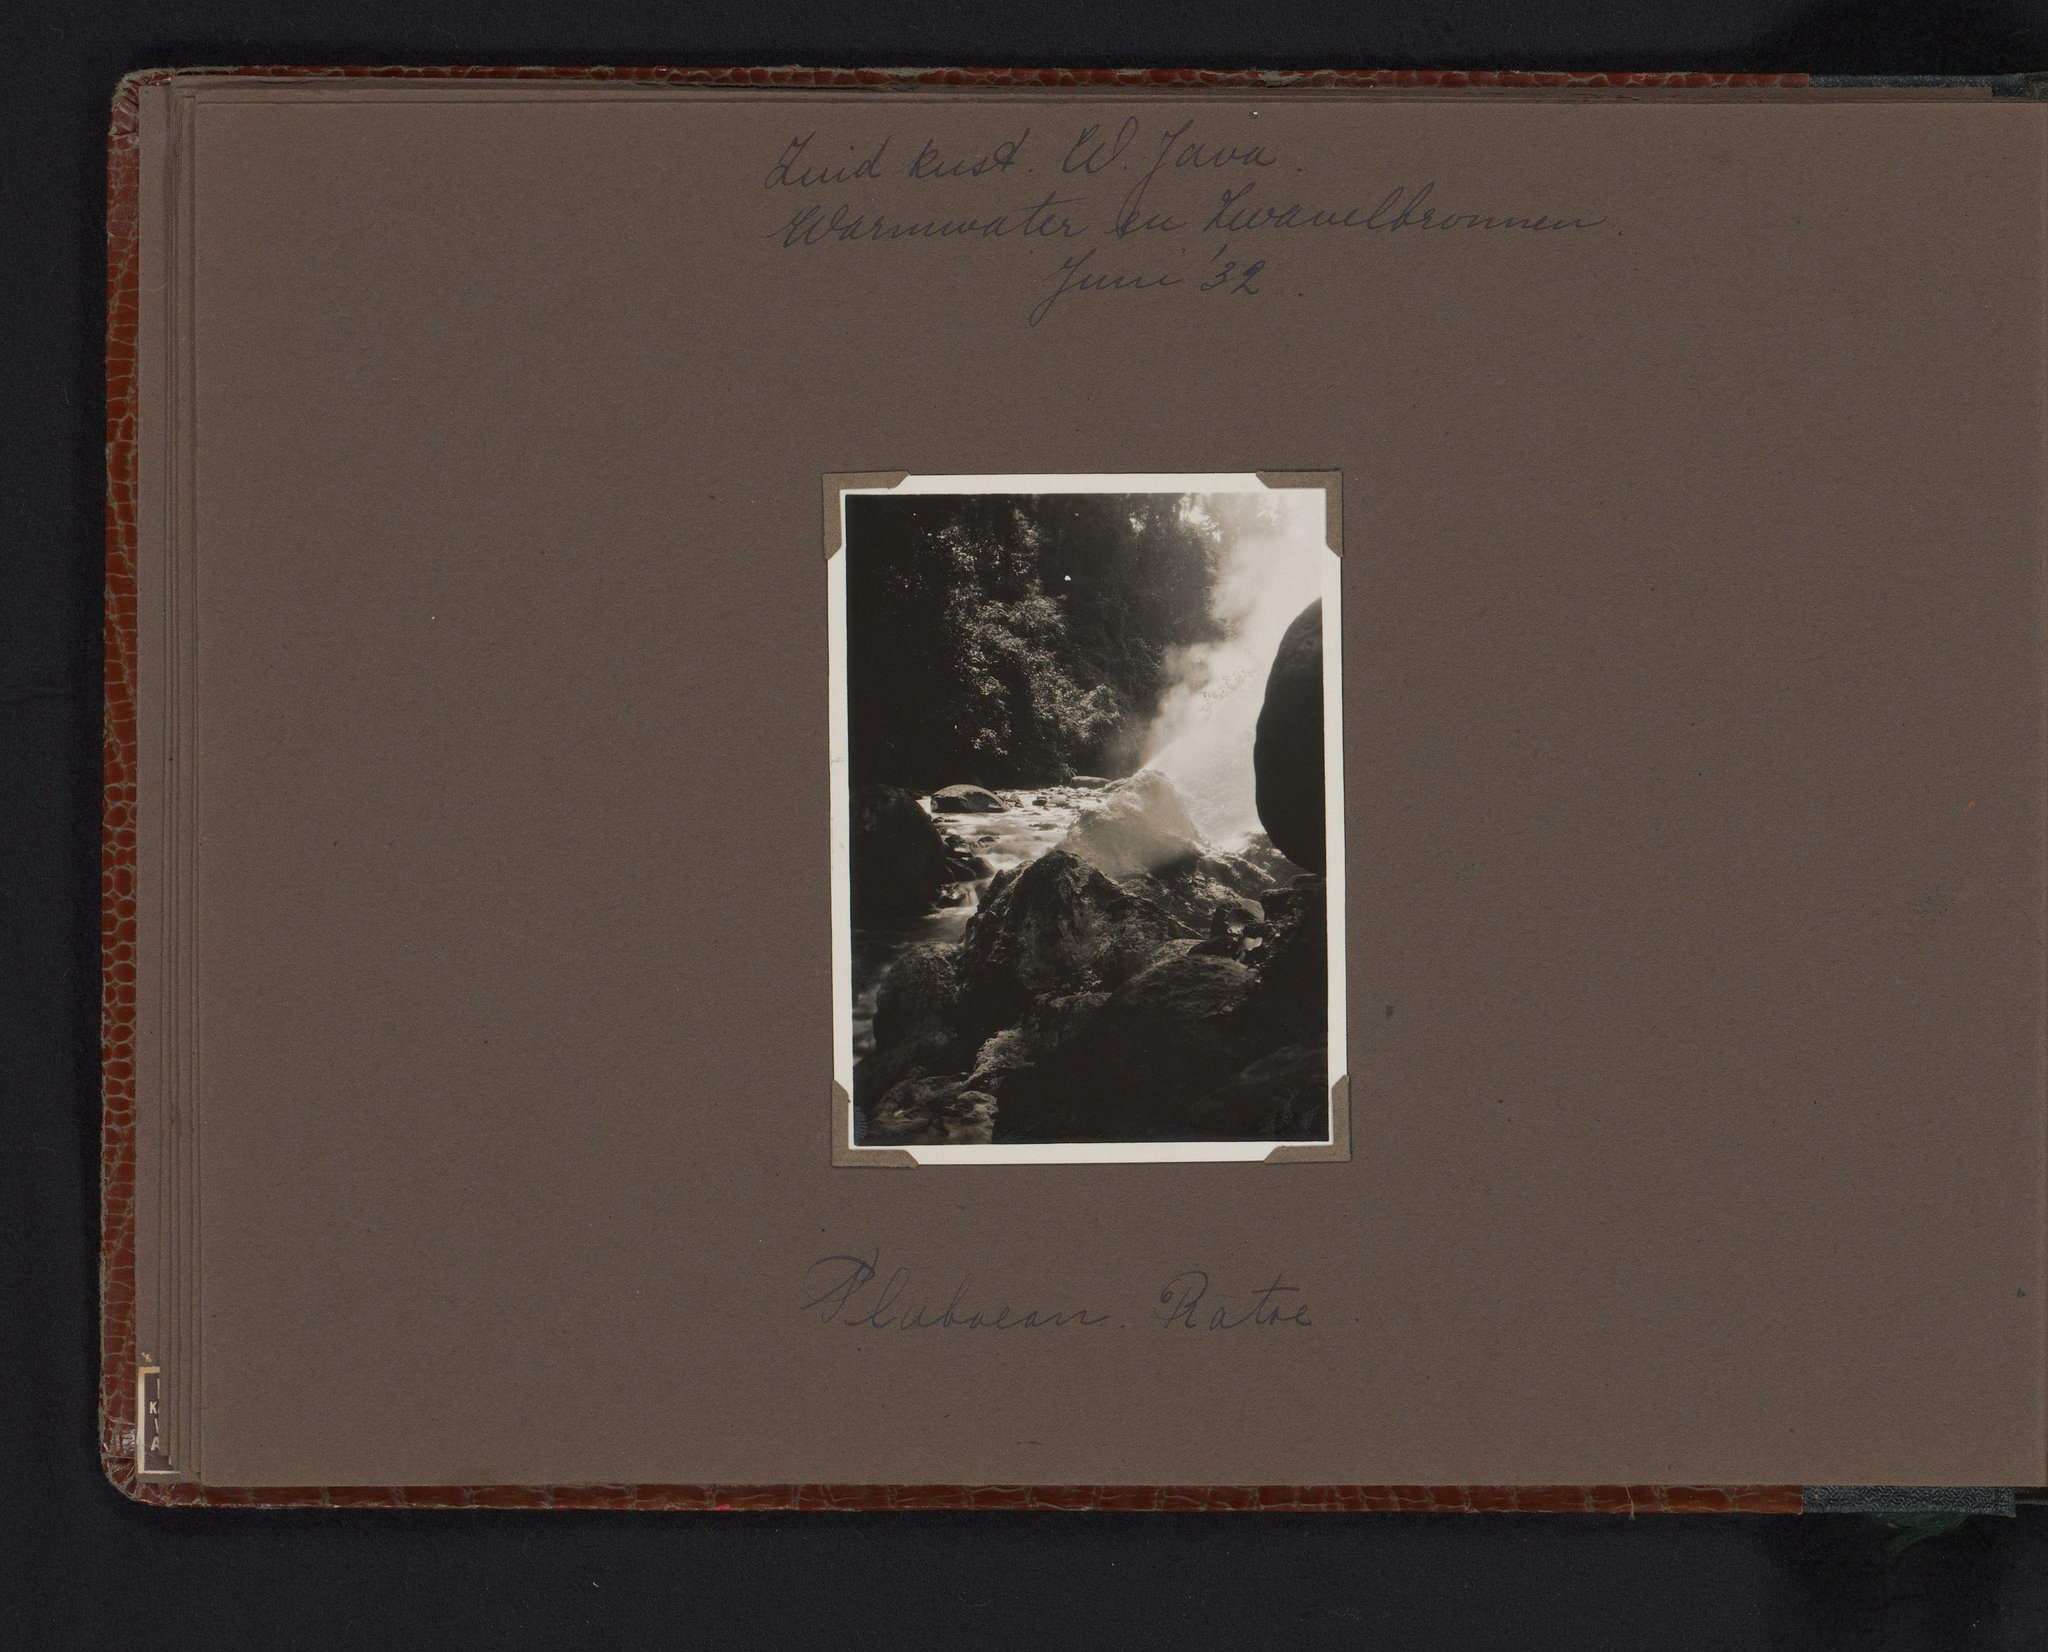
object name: photograph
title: Gezicht op warmwater en zwavelbronnen aan de zuidkust van West-Java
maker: Anonymous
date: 1906-1932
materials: paper, photographic support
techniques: gelatin silver print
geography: west java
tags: mineral water, landscapes with waters, waterscapes, seascapes (in the temperate zone)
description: Deze pagina maakt deel uit van een album.